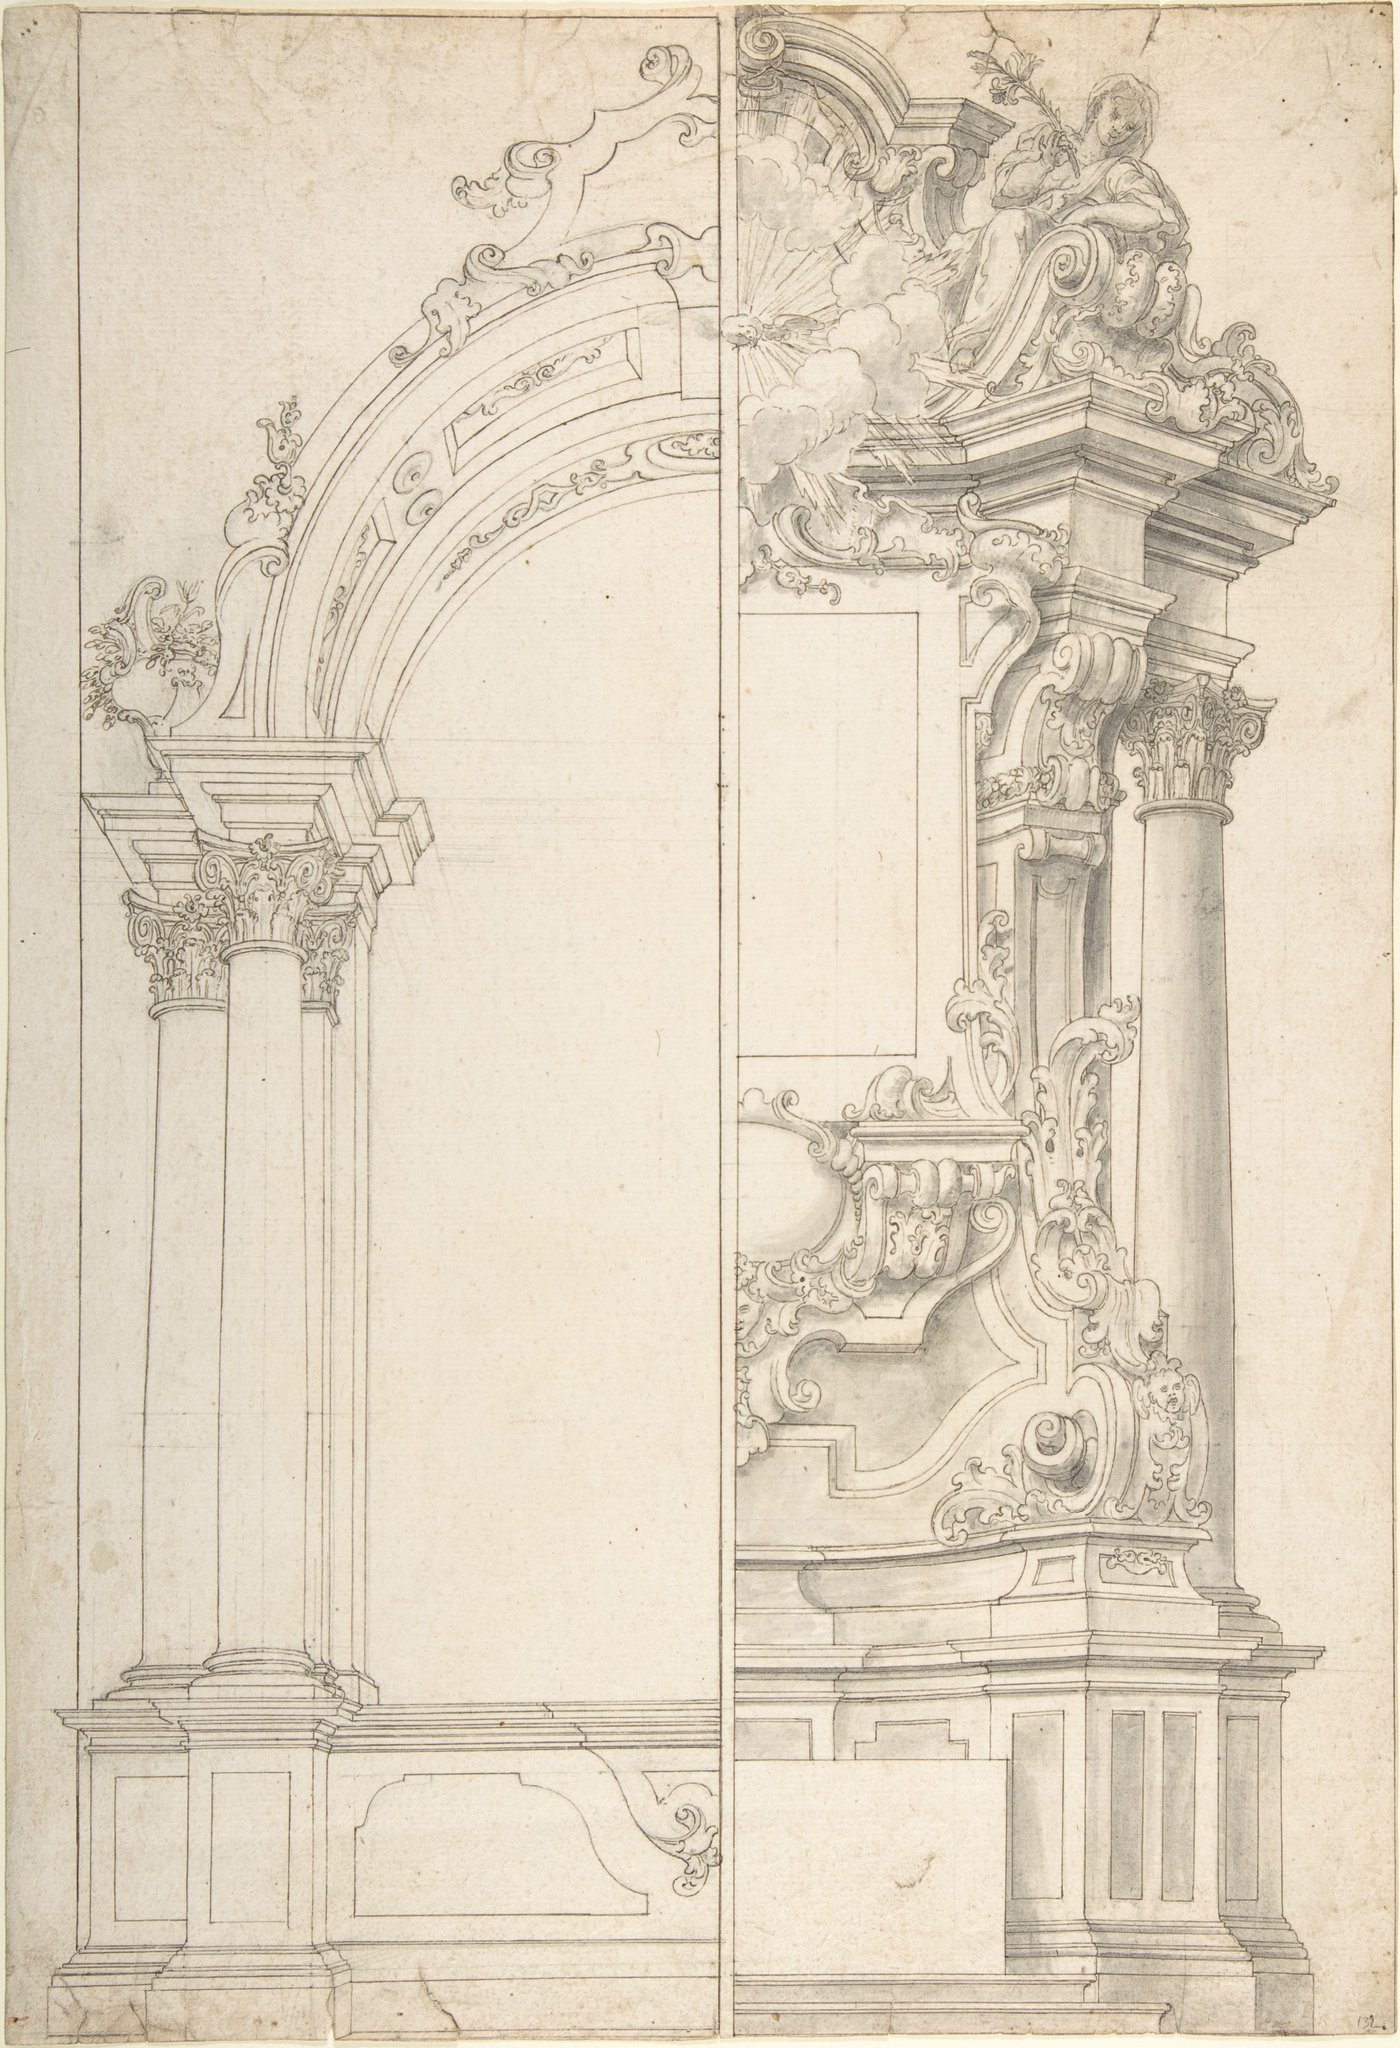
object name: drawing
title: Two Alternate Designs for an Altar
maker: anonymous, italian, piedmontese, 18th century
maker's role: artist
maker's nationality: italian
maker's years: 1700-1800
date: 1700-1780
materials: graphite, ink, drawing material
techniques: brush, pen, wash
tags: altars